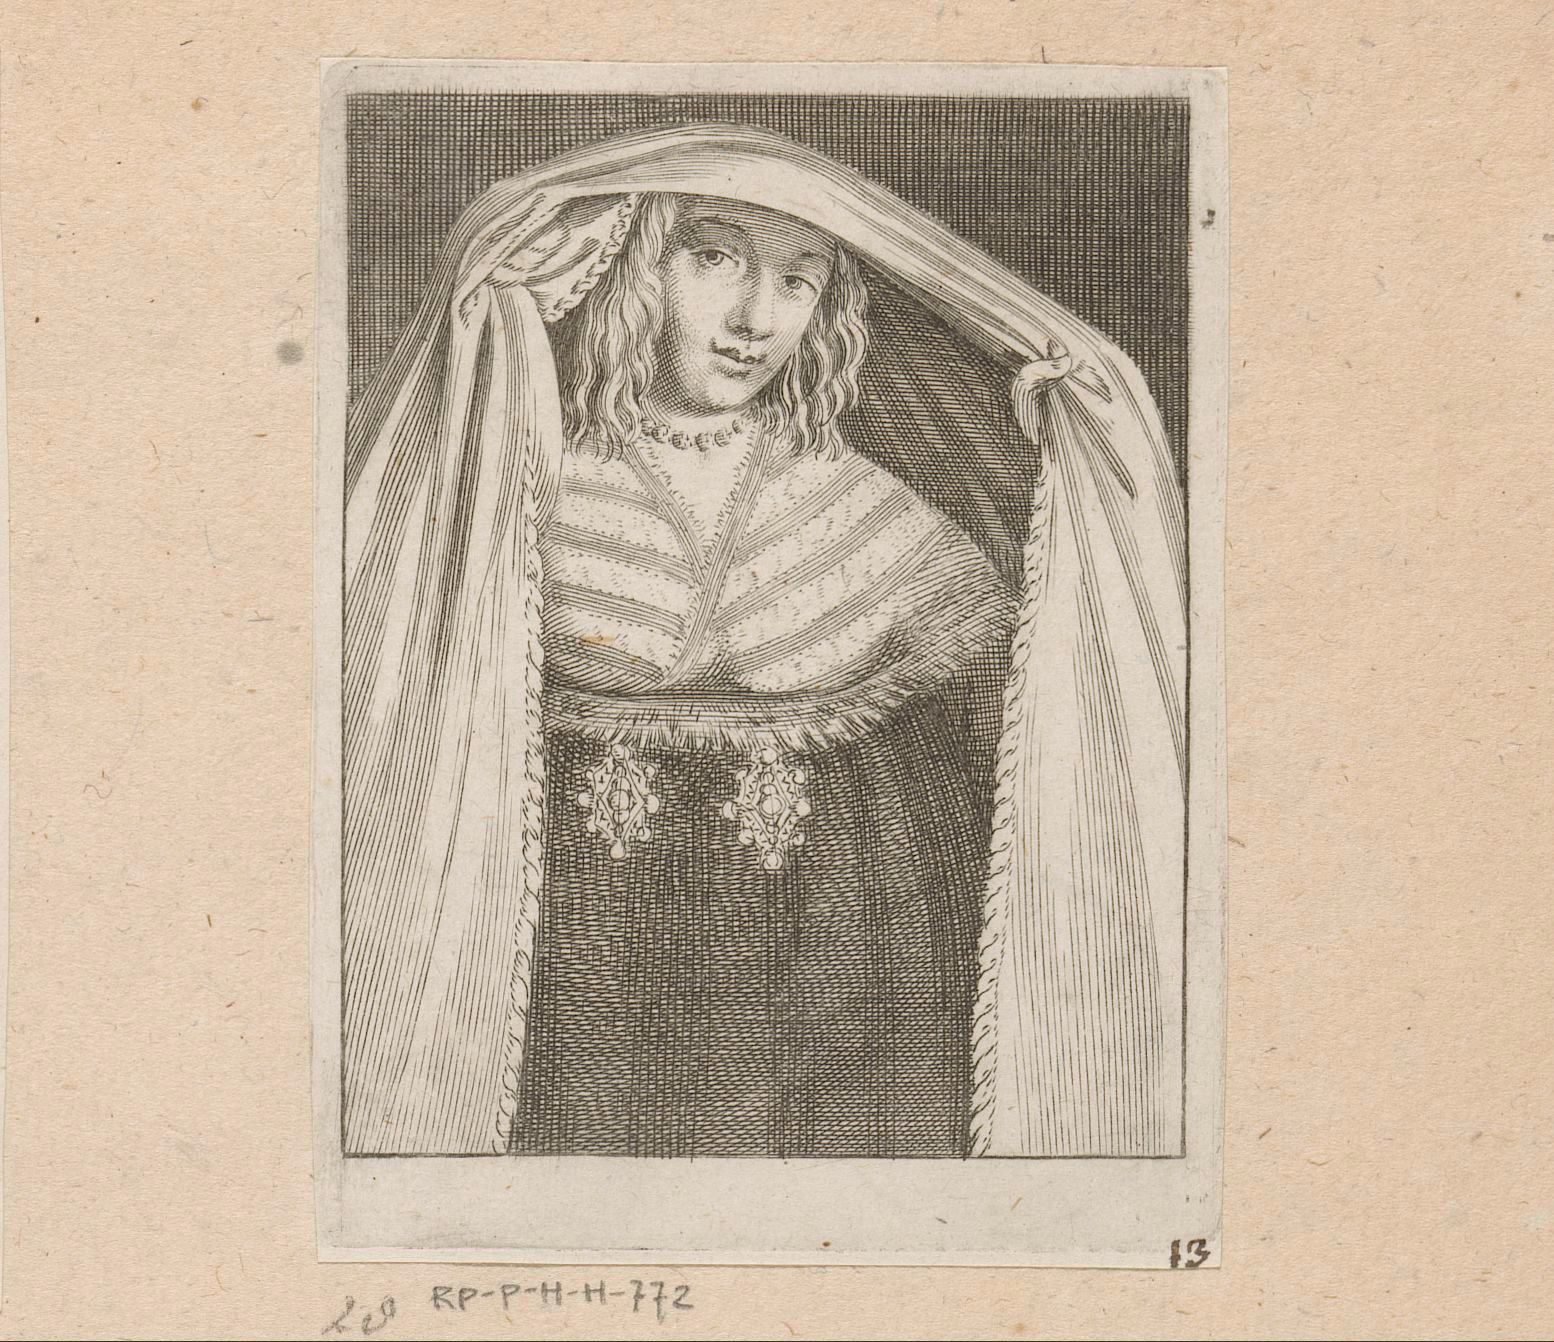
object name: print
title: Vrouw met een sluier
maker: francesco villamena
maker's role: draughtsman, painter, print maker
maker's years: 1566-1624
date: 1576-1624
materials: paper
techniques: engraving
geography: italy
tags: folk costume, regional costume, veil, covering the head, drawing drapery over the face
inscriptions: collector's mark: Lugt 10, number: ‘13’, collector's mark: Lugt 11